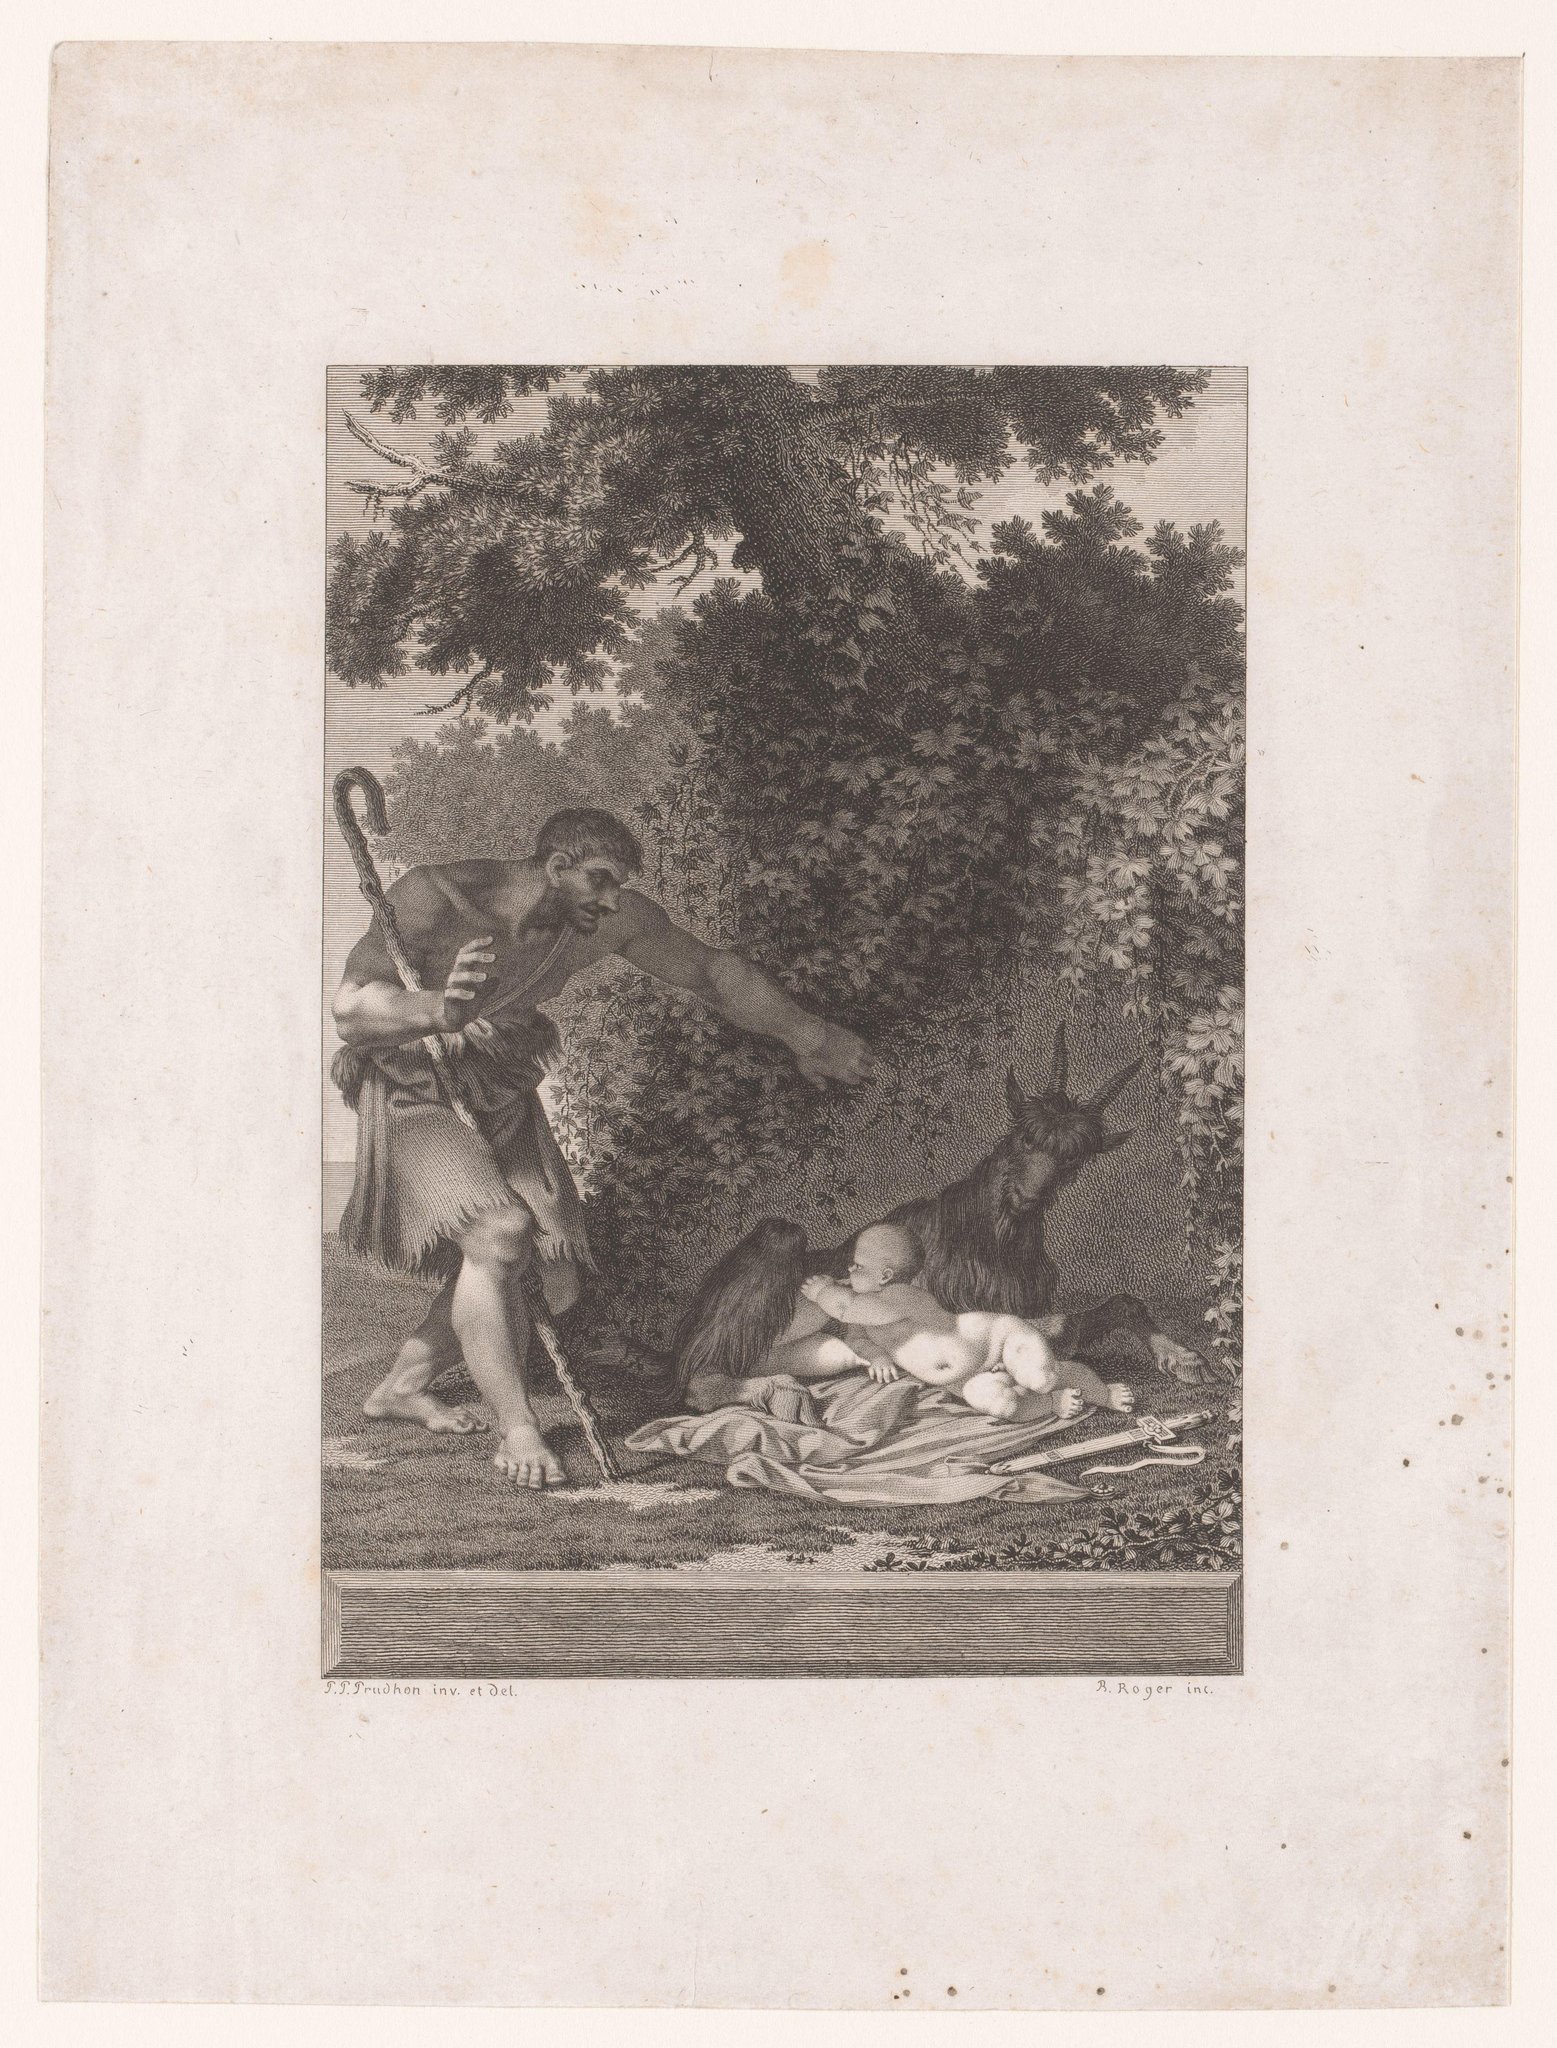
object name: print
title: Daphnis gevonden door Lamo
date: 1800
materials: paper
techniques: etching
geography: paris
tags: child suckled by animal, daphnis (in greek mythology a shepherd who invented pastoral poetry, goat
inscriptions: collector's mark: Lugt 2228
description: Prent uit: Amyot, Jacques. Les Amours pastorales de Daphnis et de Chloé (...). Parijs: François-Ambroise Didot, 1800.